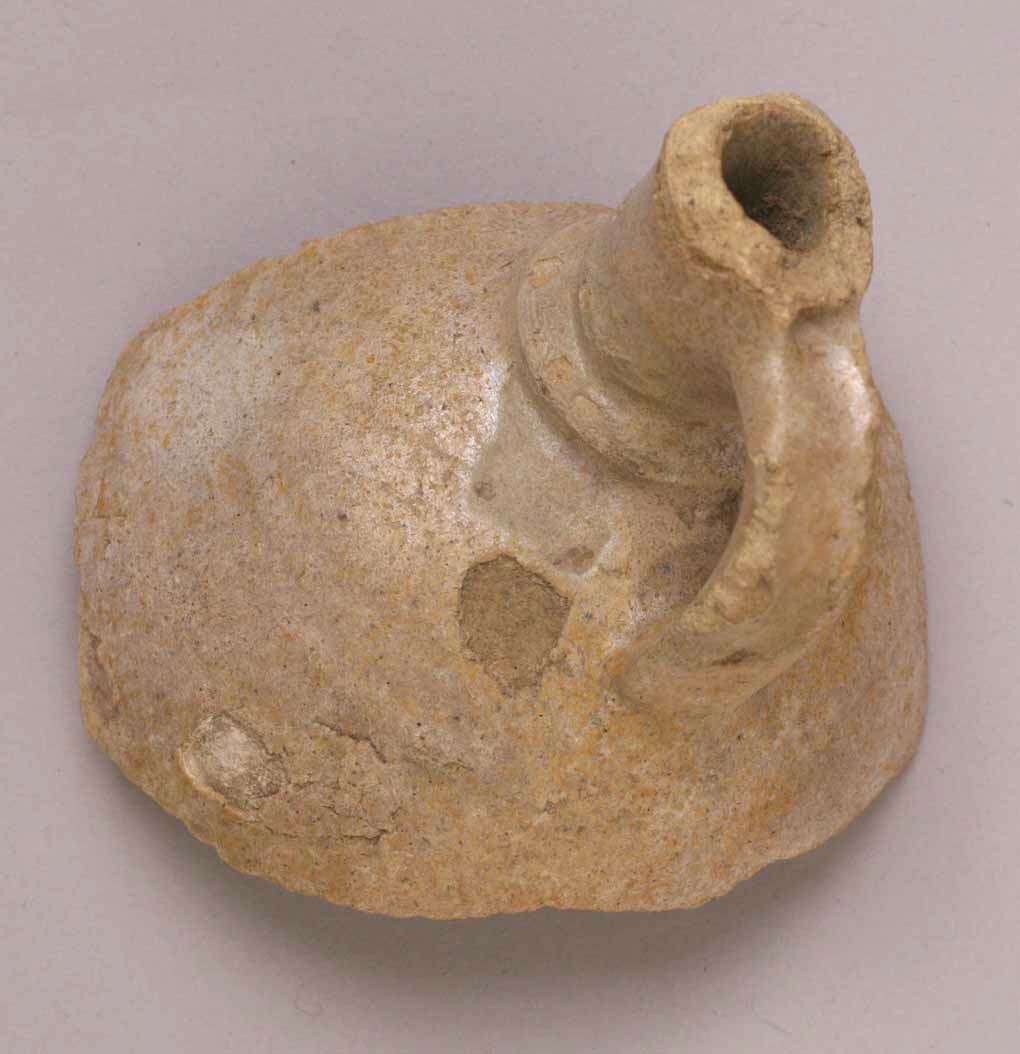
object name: jug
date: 201-700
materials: earthenware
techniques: glazing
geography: iraq